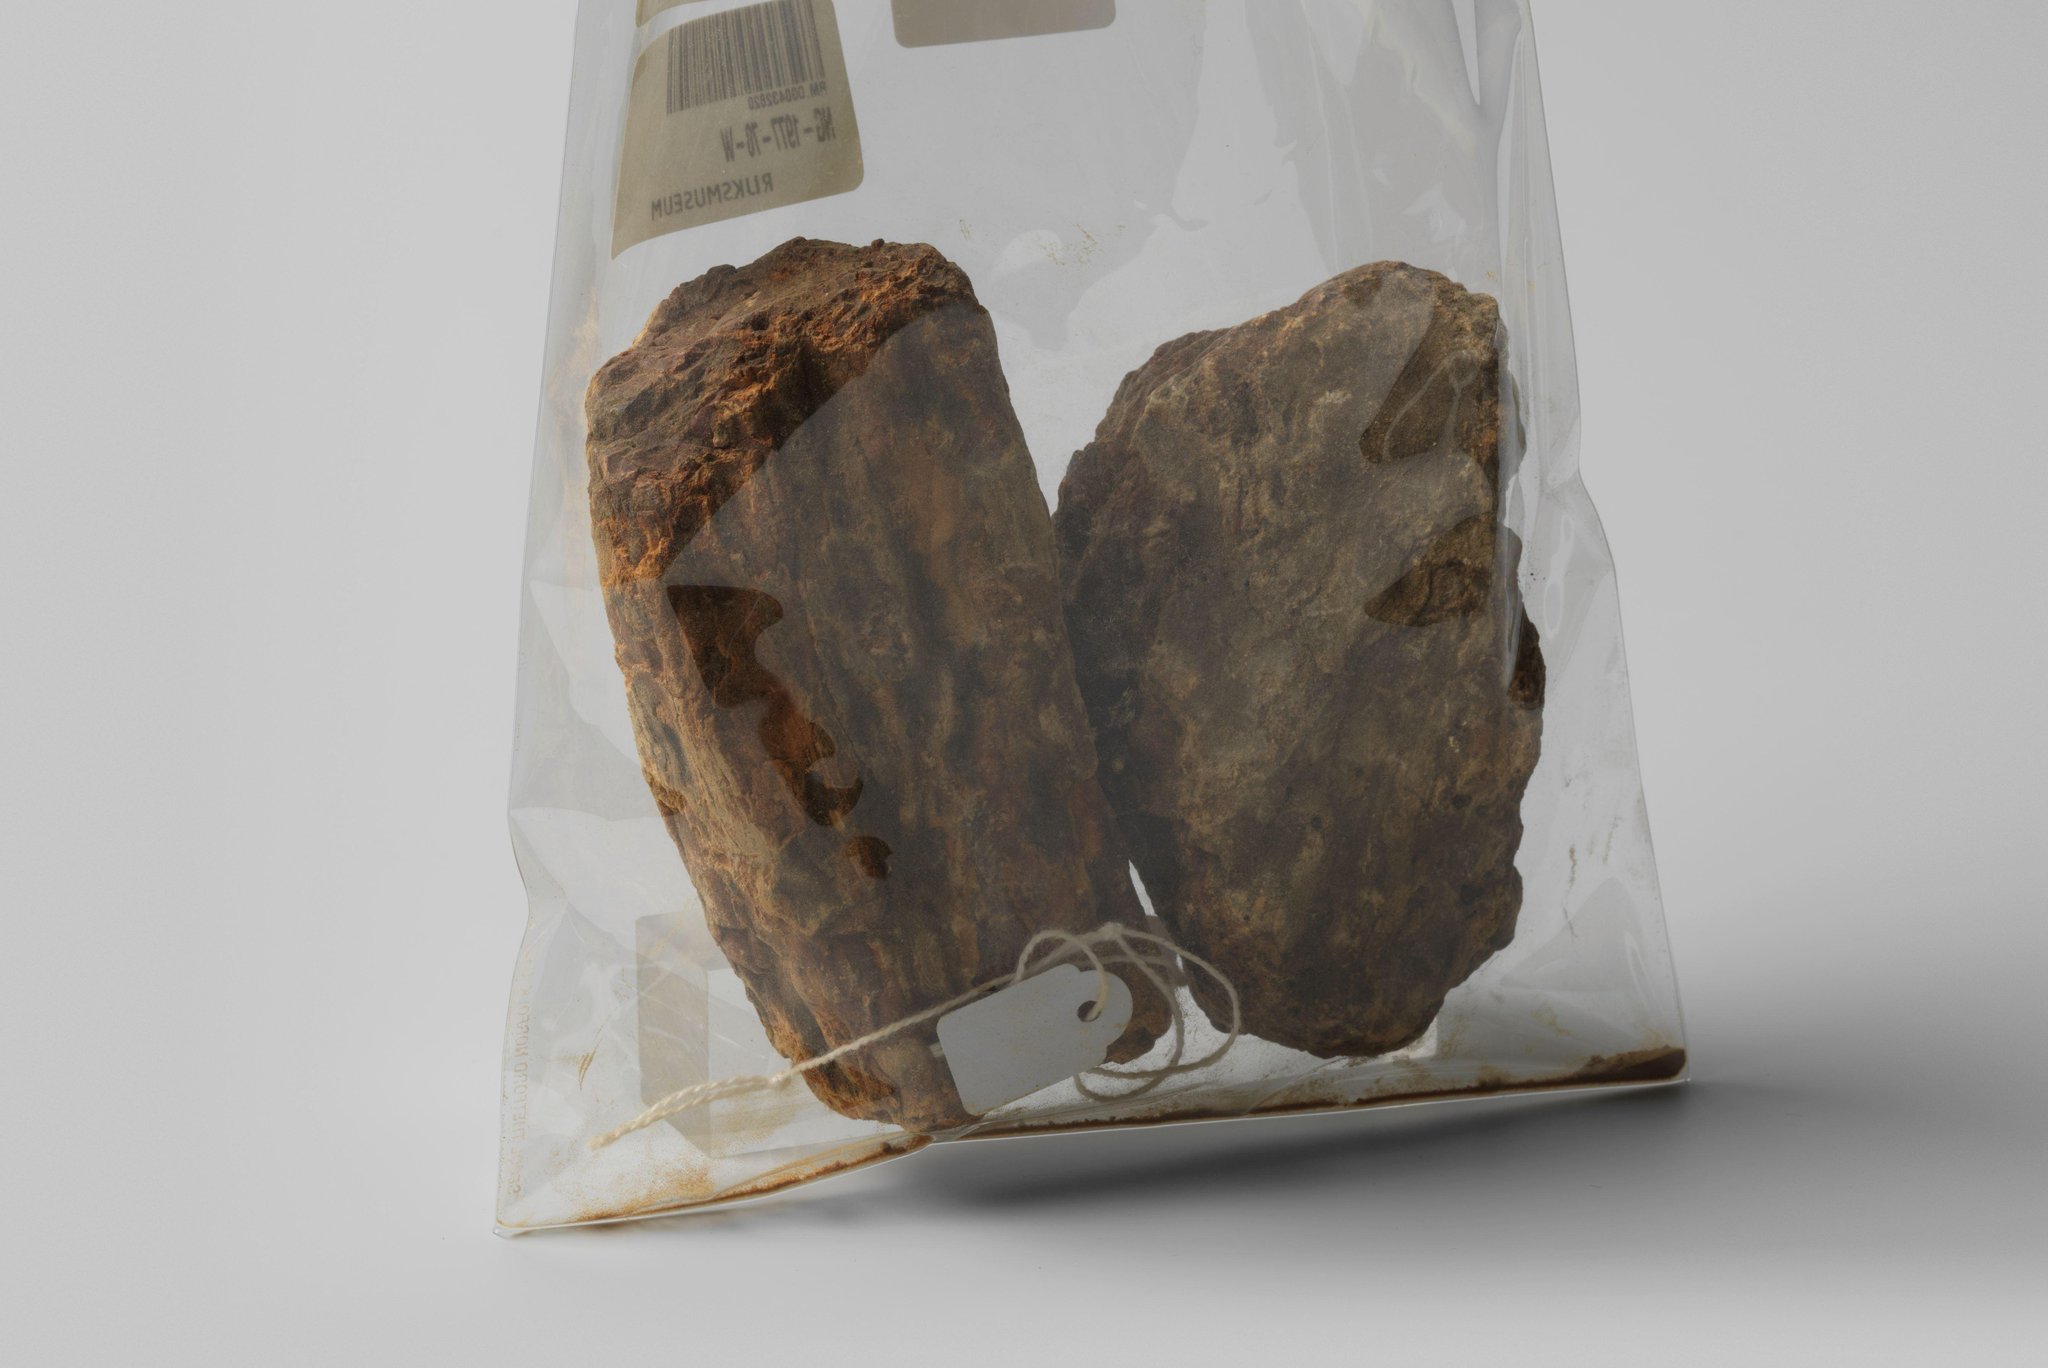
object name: artifact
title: Brok uit V.O.C.-schip de 'Witte Leeuw'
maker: Anonymous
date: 1613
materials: pigment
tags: verenigde oostindische compagnie, sint-helena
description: Brok uit V.O.C.-schip de 'Witte Leeuw', loodwit, grondstof voor verf.